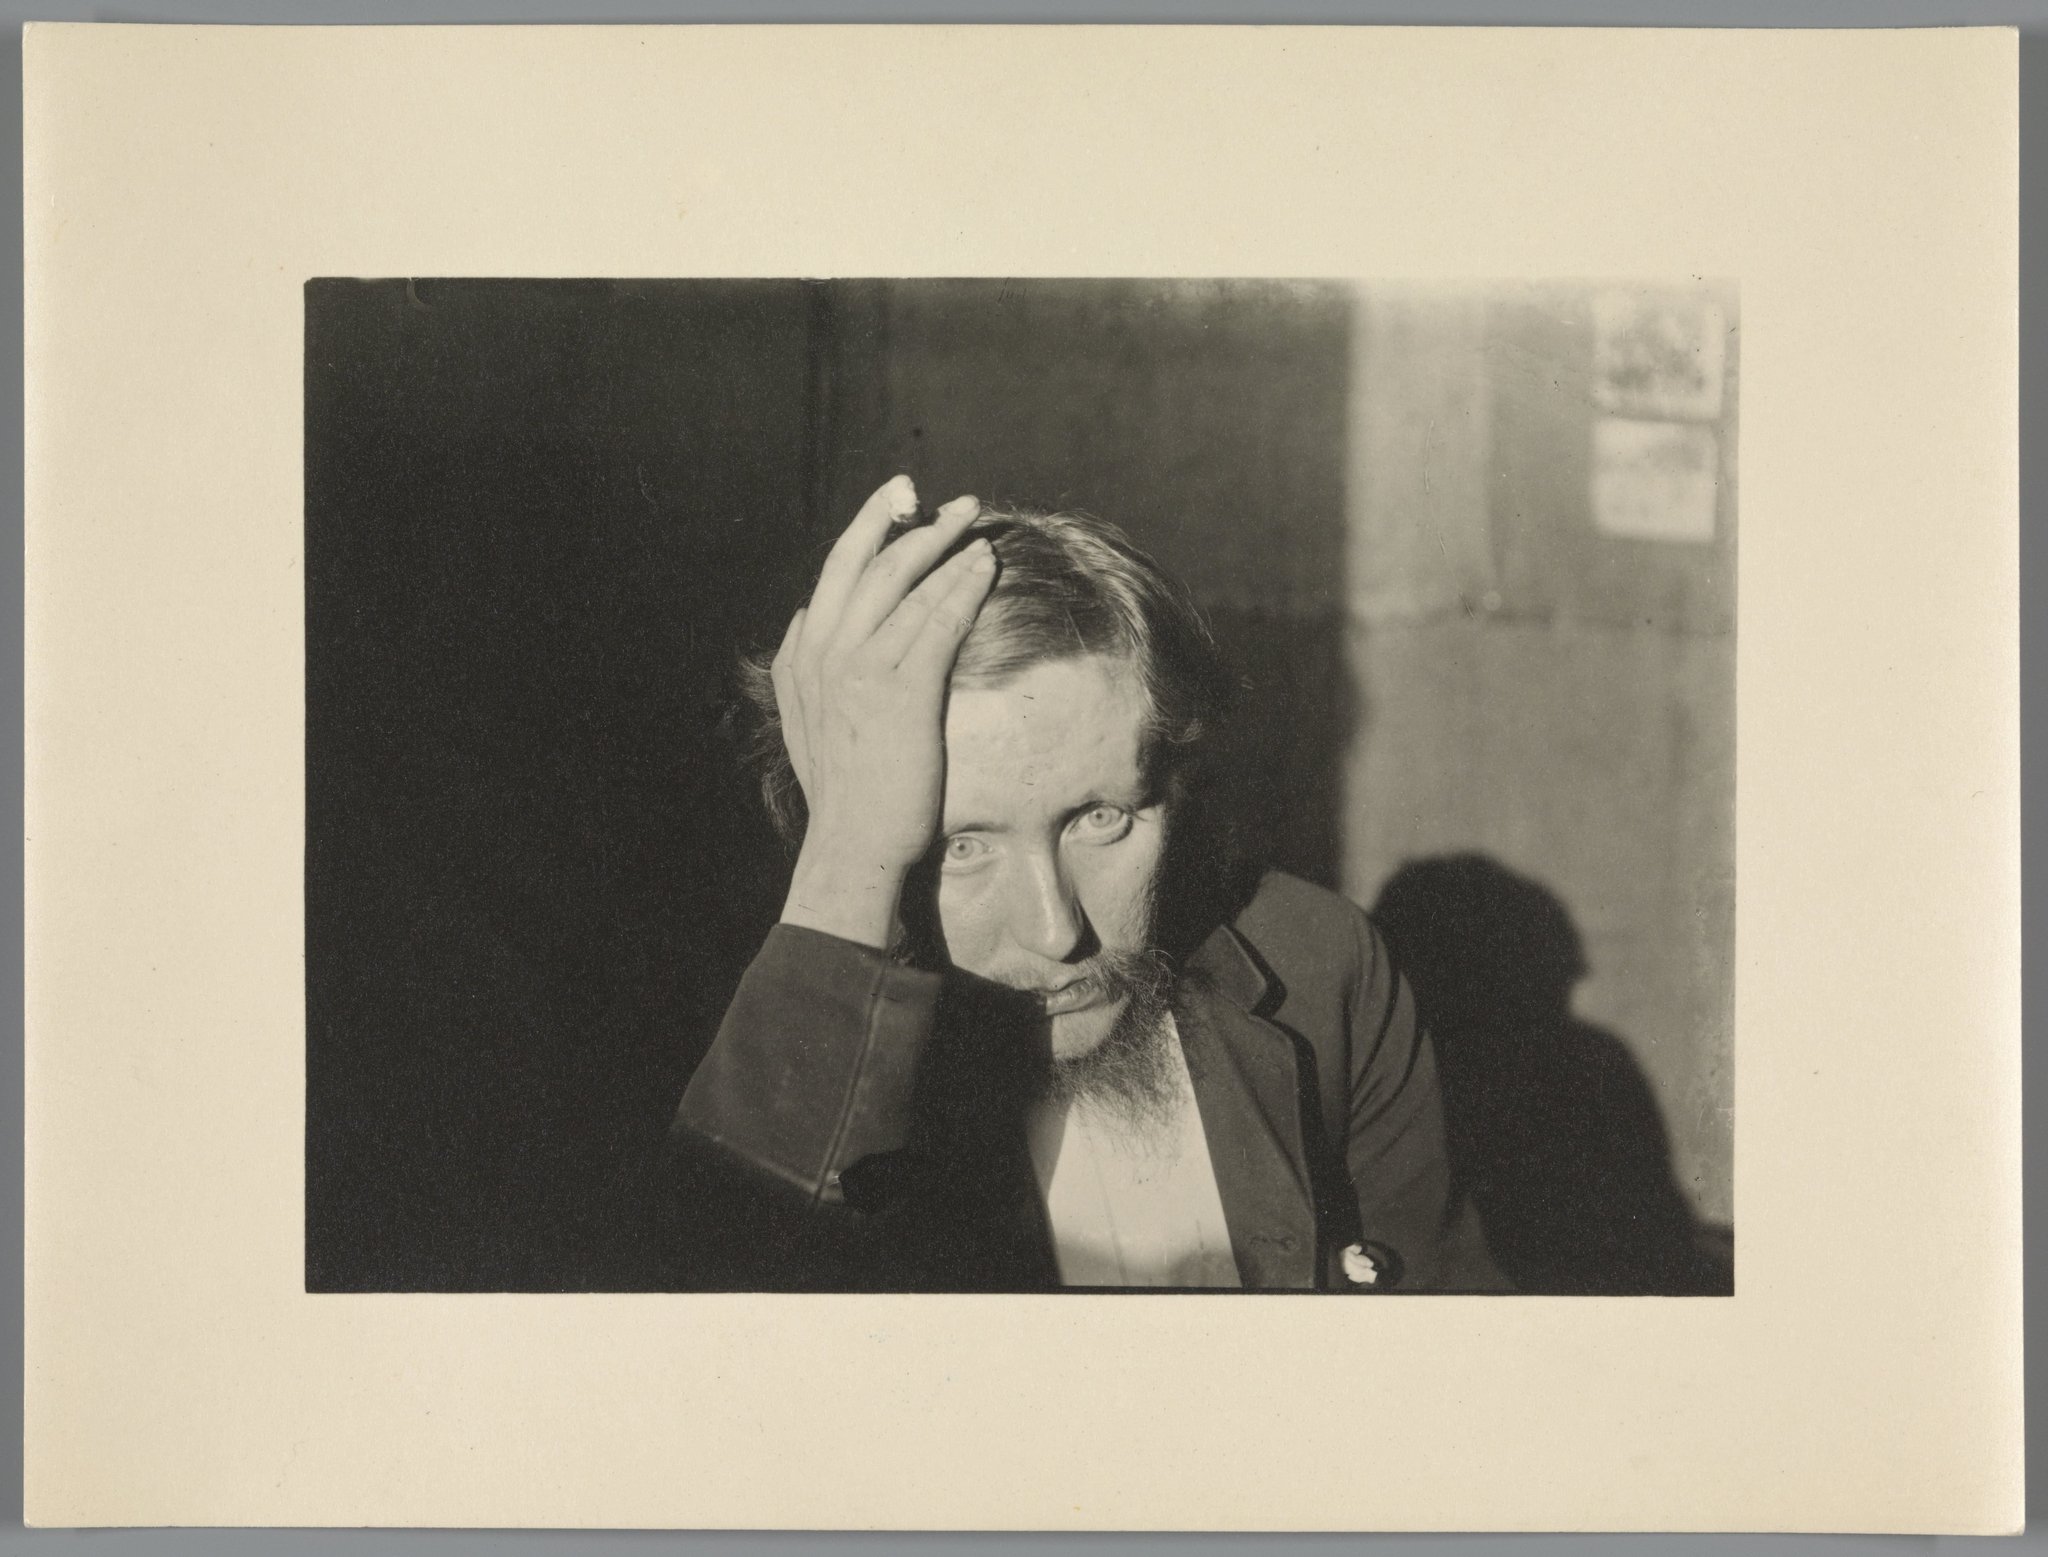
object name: photograph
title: Reproductie naar een foto van Willem Witsen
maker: Anonymous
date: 1860-1915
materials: paper, photographic support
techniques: gelatin silver print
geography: netherlands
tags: the hague, willem kloos